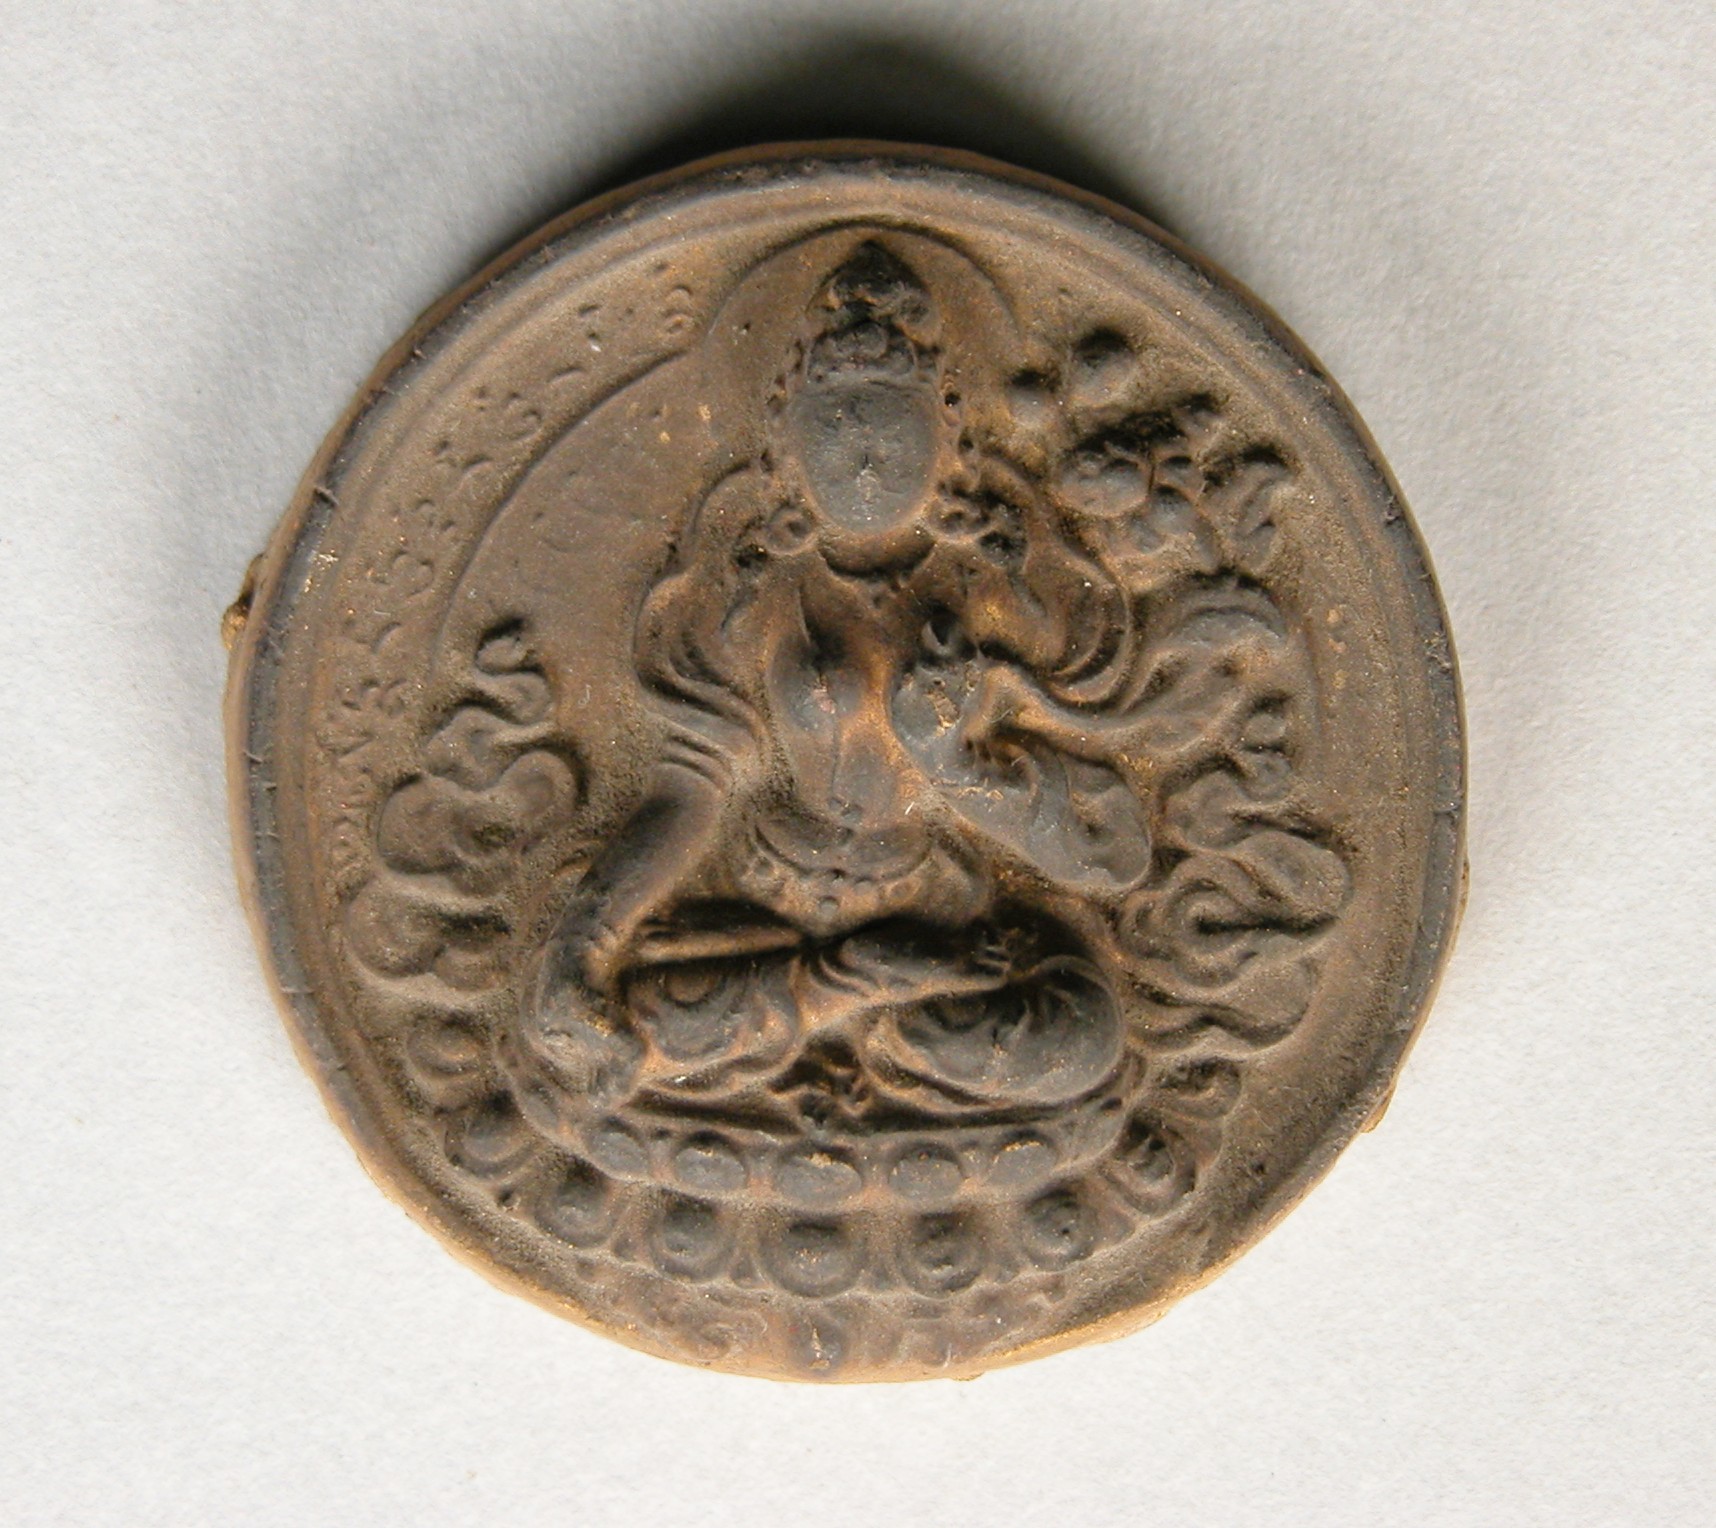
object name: plaque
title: Votive Plaque with White Taras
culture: tibetan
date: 1368-1643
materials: clay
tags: buddhism,deities